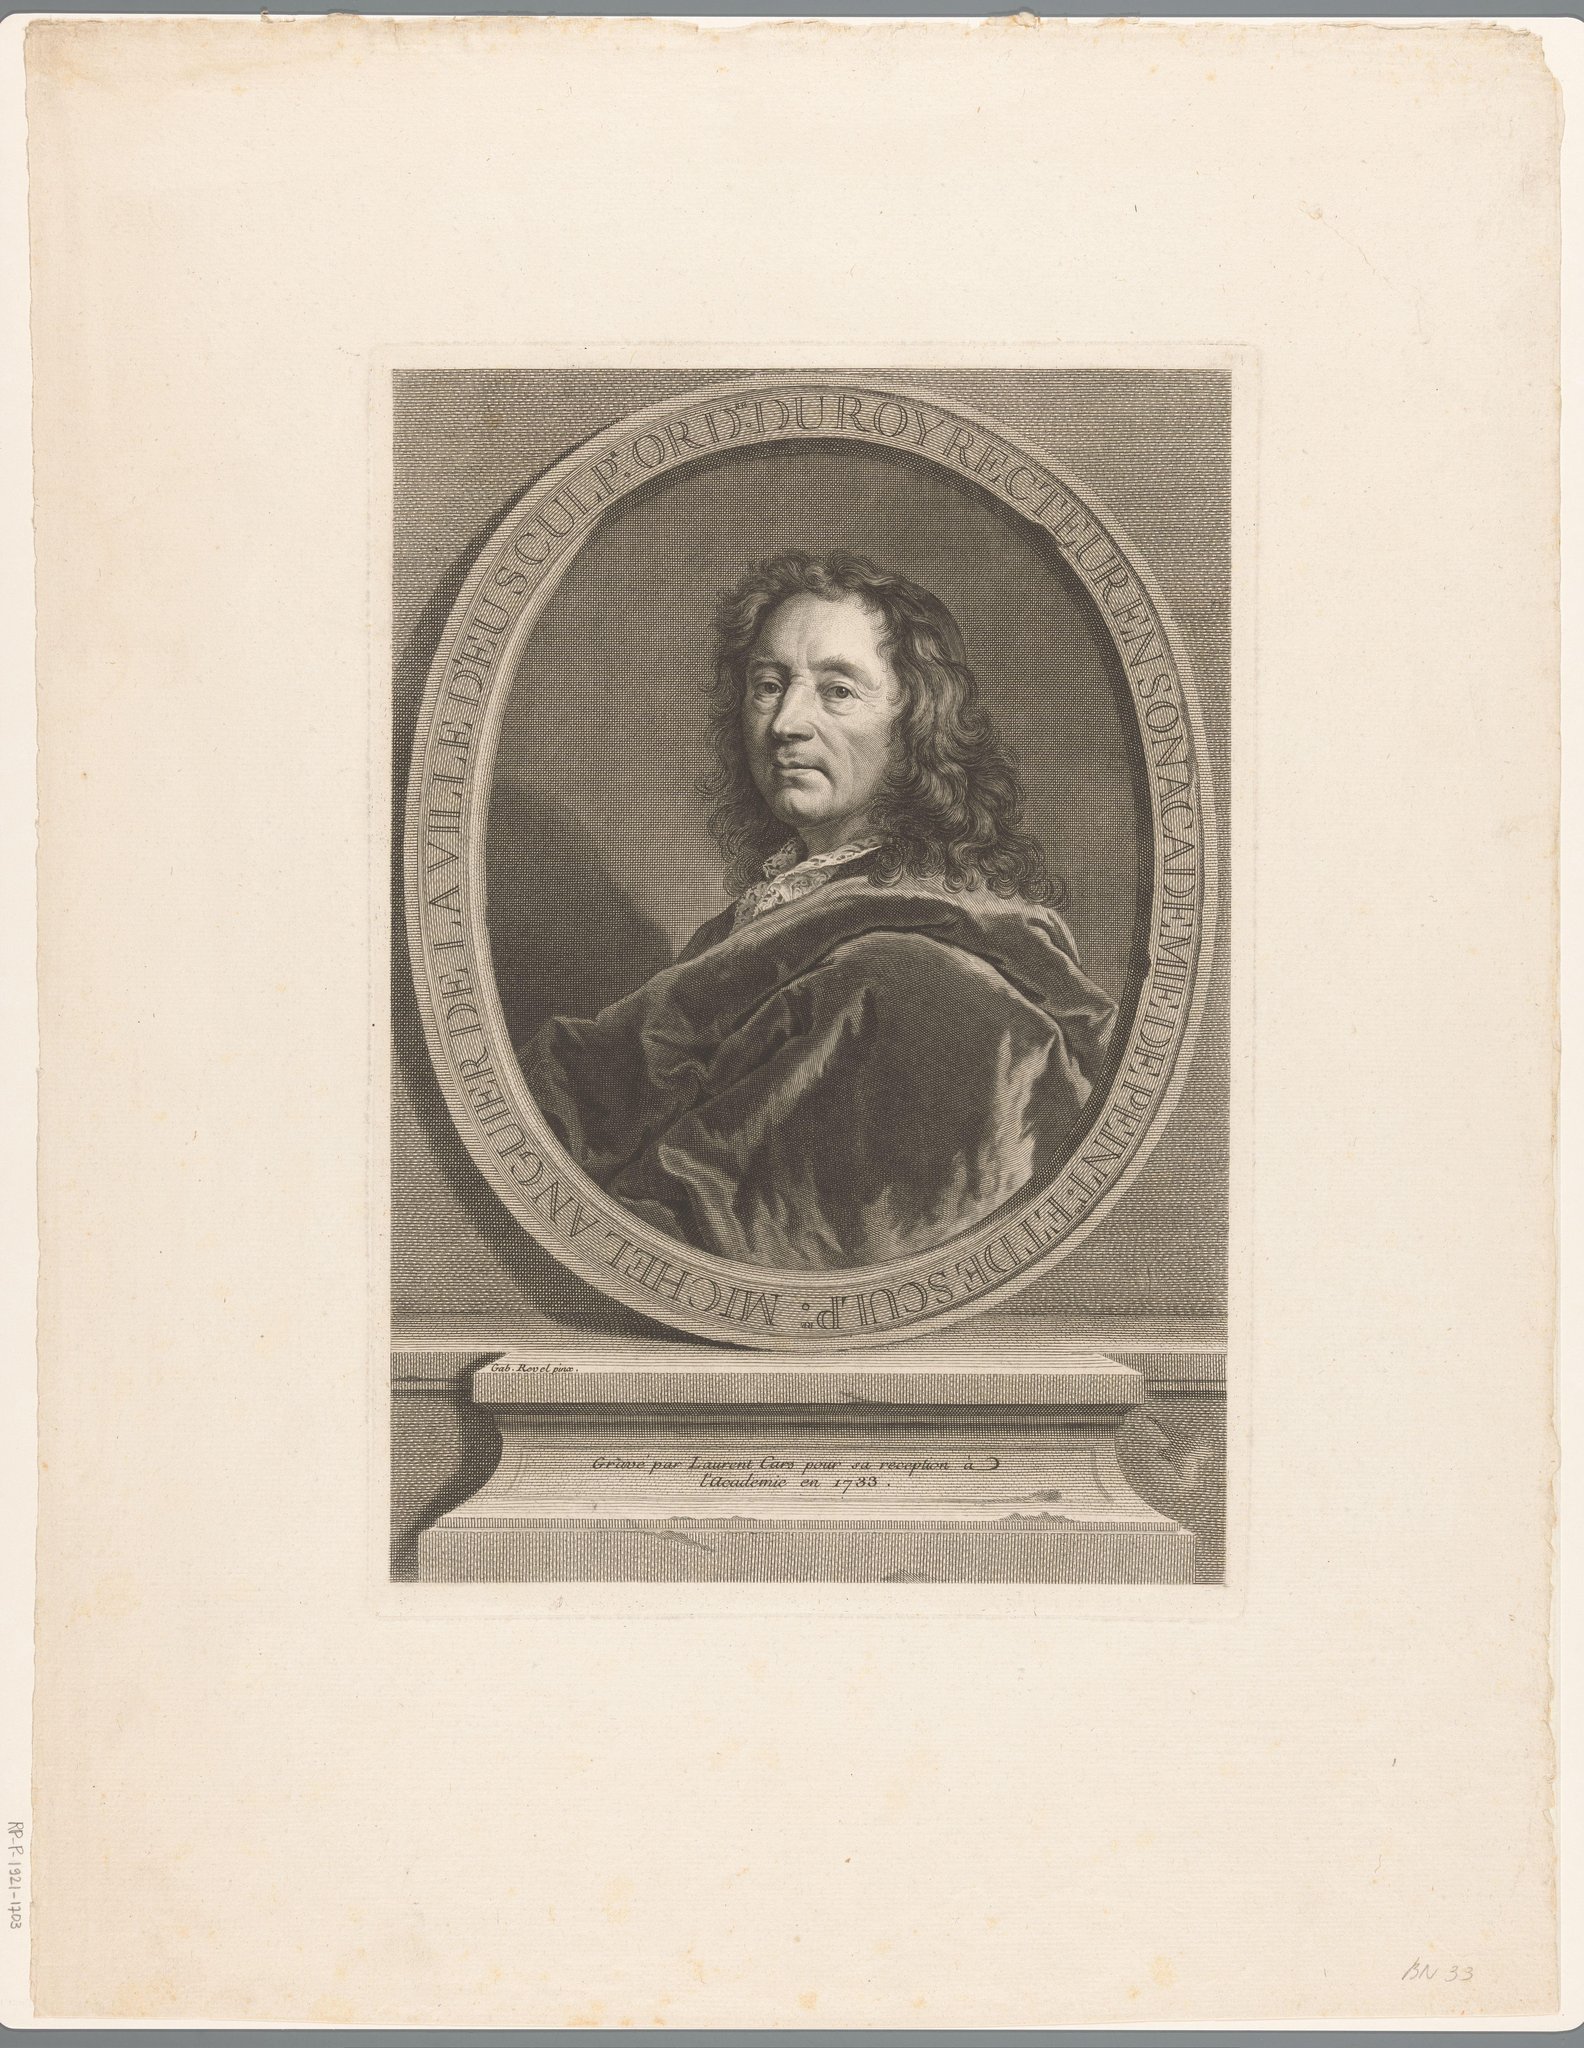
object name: print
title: Portret van Michel Anguier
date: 1733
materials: paper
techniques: engraving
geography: france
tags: paris, sculptor, michel anguier, portrait, self-portrait of sculptor, historical persons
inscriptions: collector's mark: Lugt 2233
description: Vervaardigd voor zijn toetreden tot de Académie Royale op 31 december 1733, evenals het portret van Sébastien Bourdon naar Hyacinthe Rigaud (RP-P-OB-42.432).